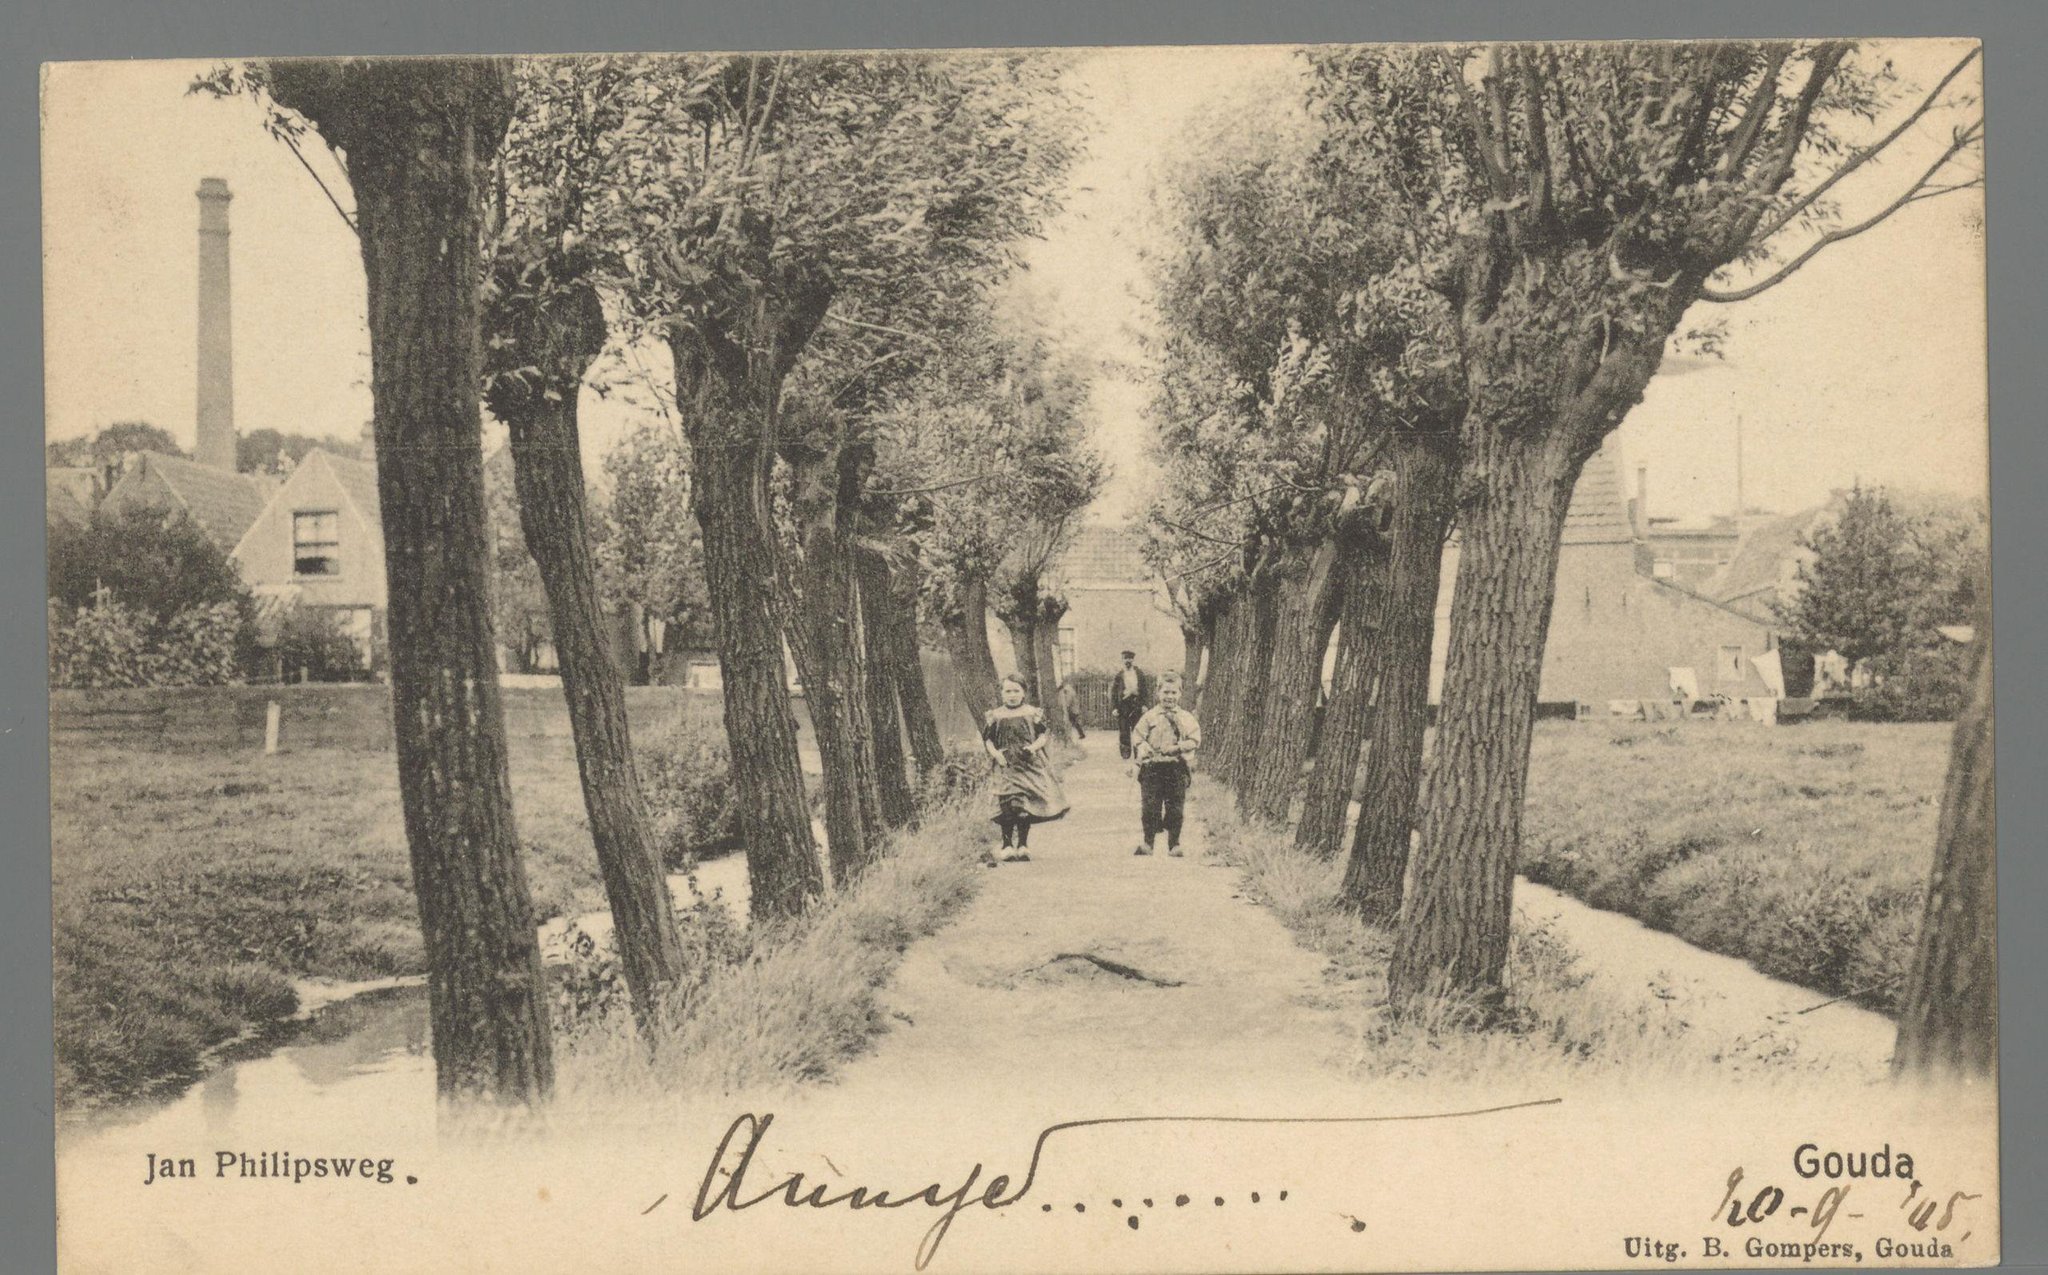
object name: ansichtkaart, prentbriefkaart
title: Jan Philipsweg. Gouda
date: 1897-1905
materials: cardboard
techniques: photograph, writing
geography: gouda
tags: road, path, trees: willow, gouda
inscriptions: postage stamp